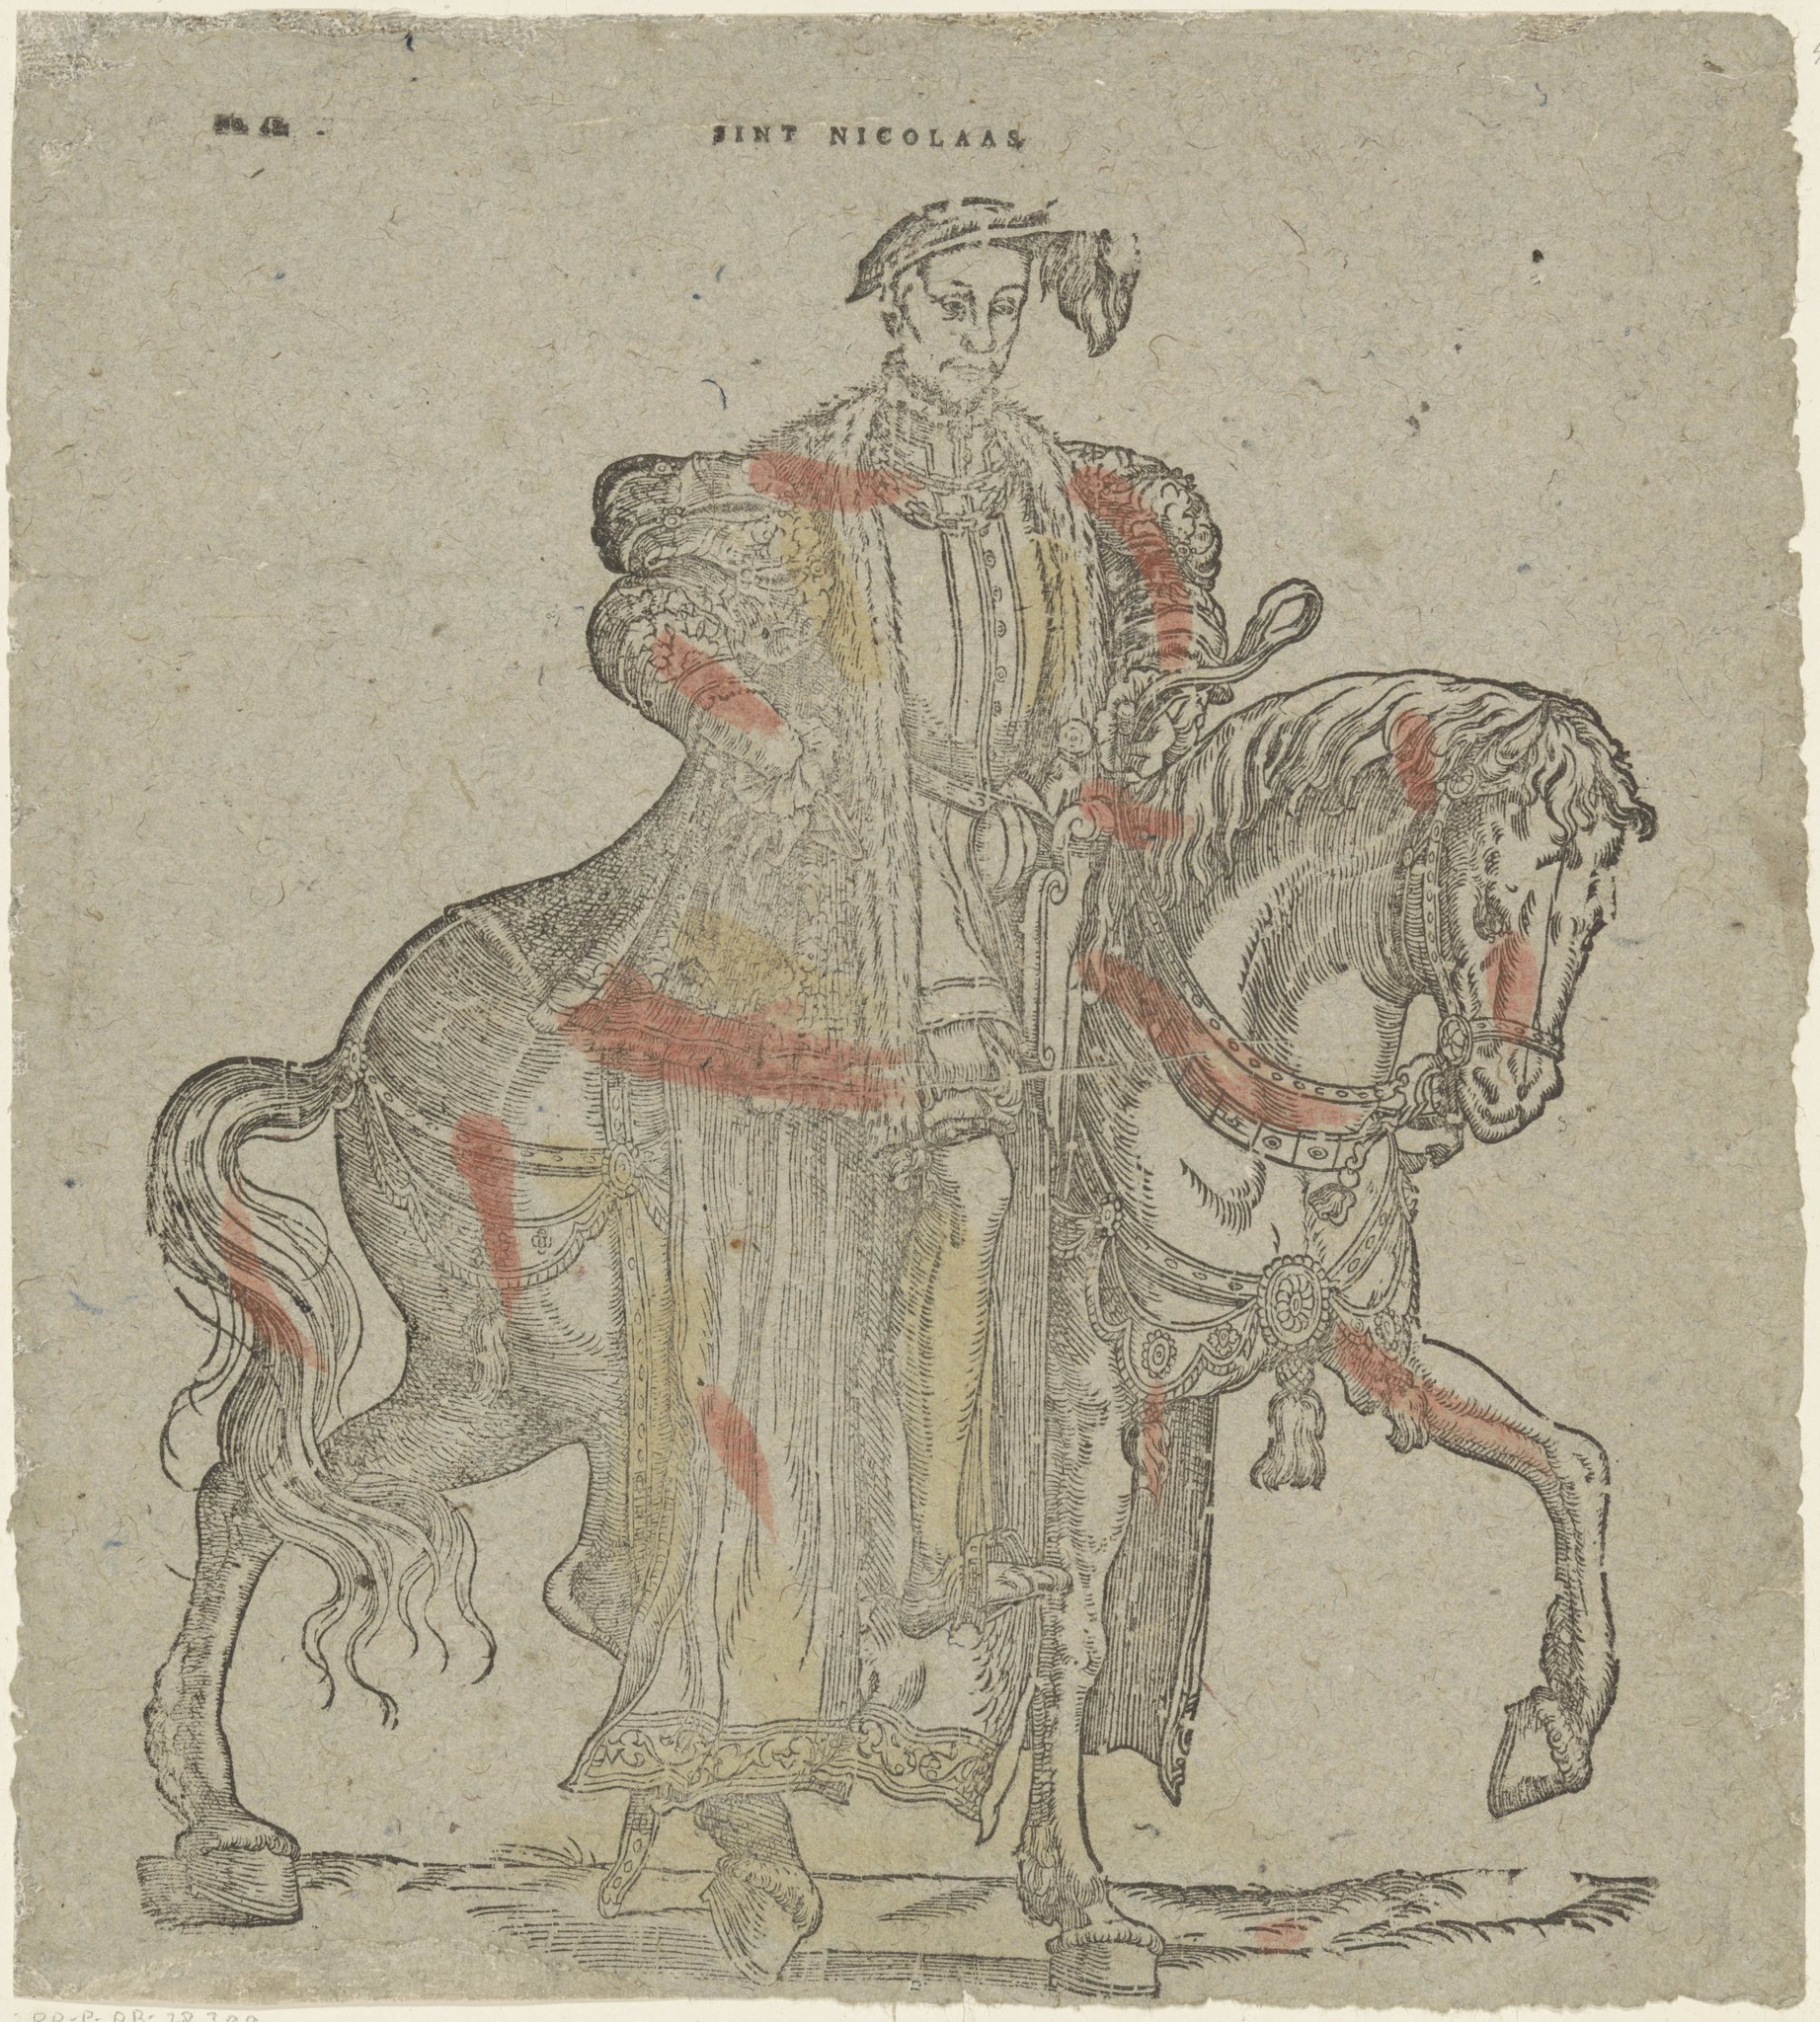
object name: print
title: Sint Nicolaas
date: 1757-1830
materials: paper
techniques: colour, letterpress printing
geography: amsterdam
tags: the bishop nicholas of myra (or bari); possible attributes: anchor, boat, three golden balls (on a book), three purses, three children in a tub, three maidens, festivities on st. nicholas (eve) (december 5)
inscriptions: collector's mark: Lugt 2760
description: Blad met een grote voorstelling van Sint Nicolaas als baardeloze jonge man, rijdend op zijn paard. Hij is gekleed in 16e-eeuwse kleding (een lange mantel afgezet met bont, over wambuis en kniebroek, op zijn hoofd een baret met veer). Genummerd linksboven: No. 42.